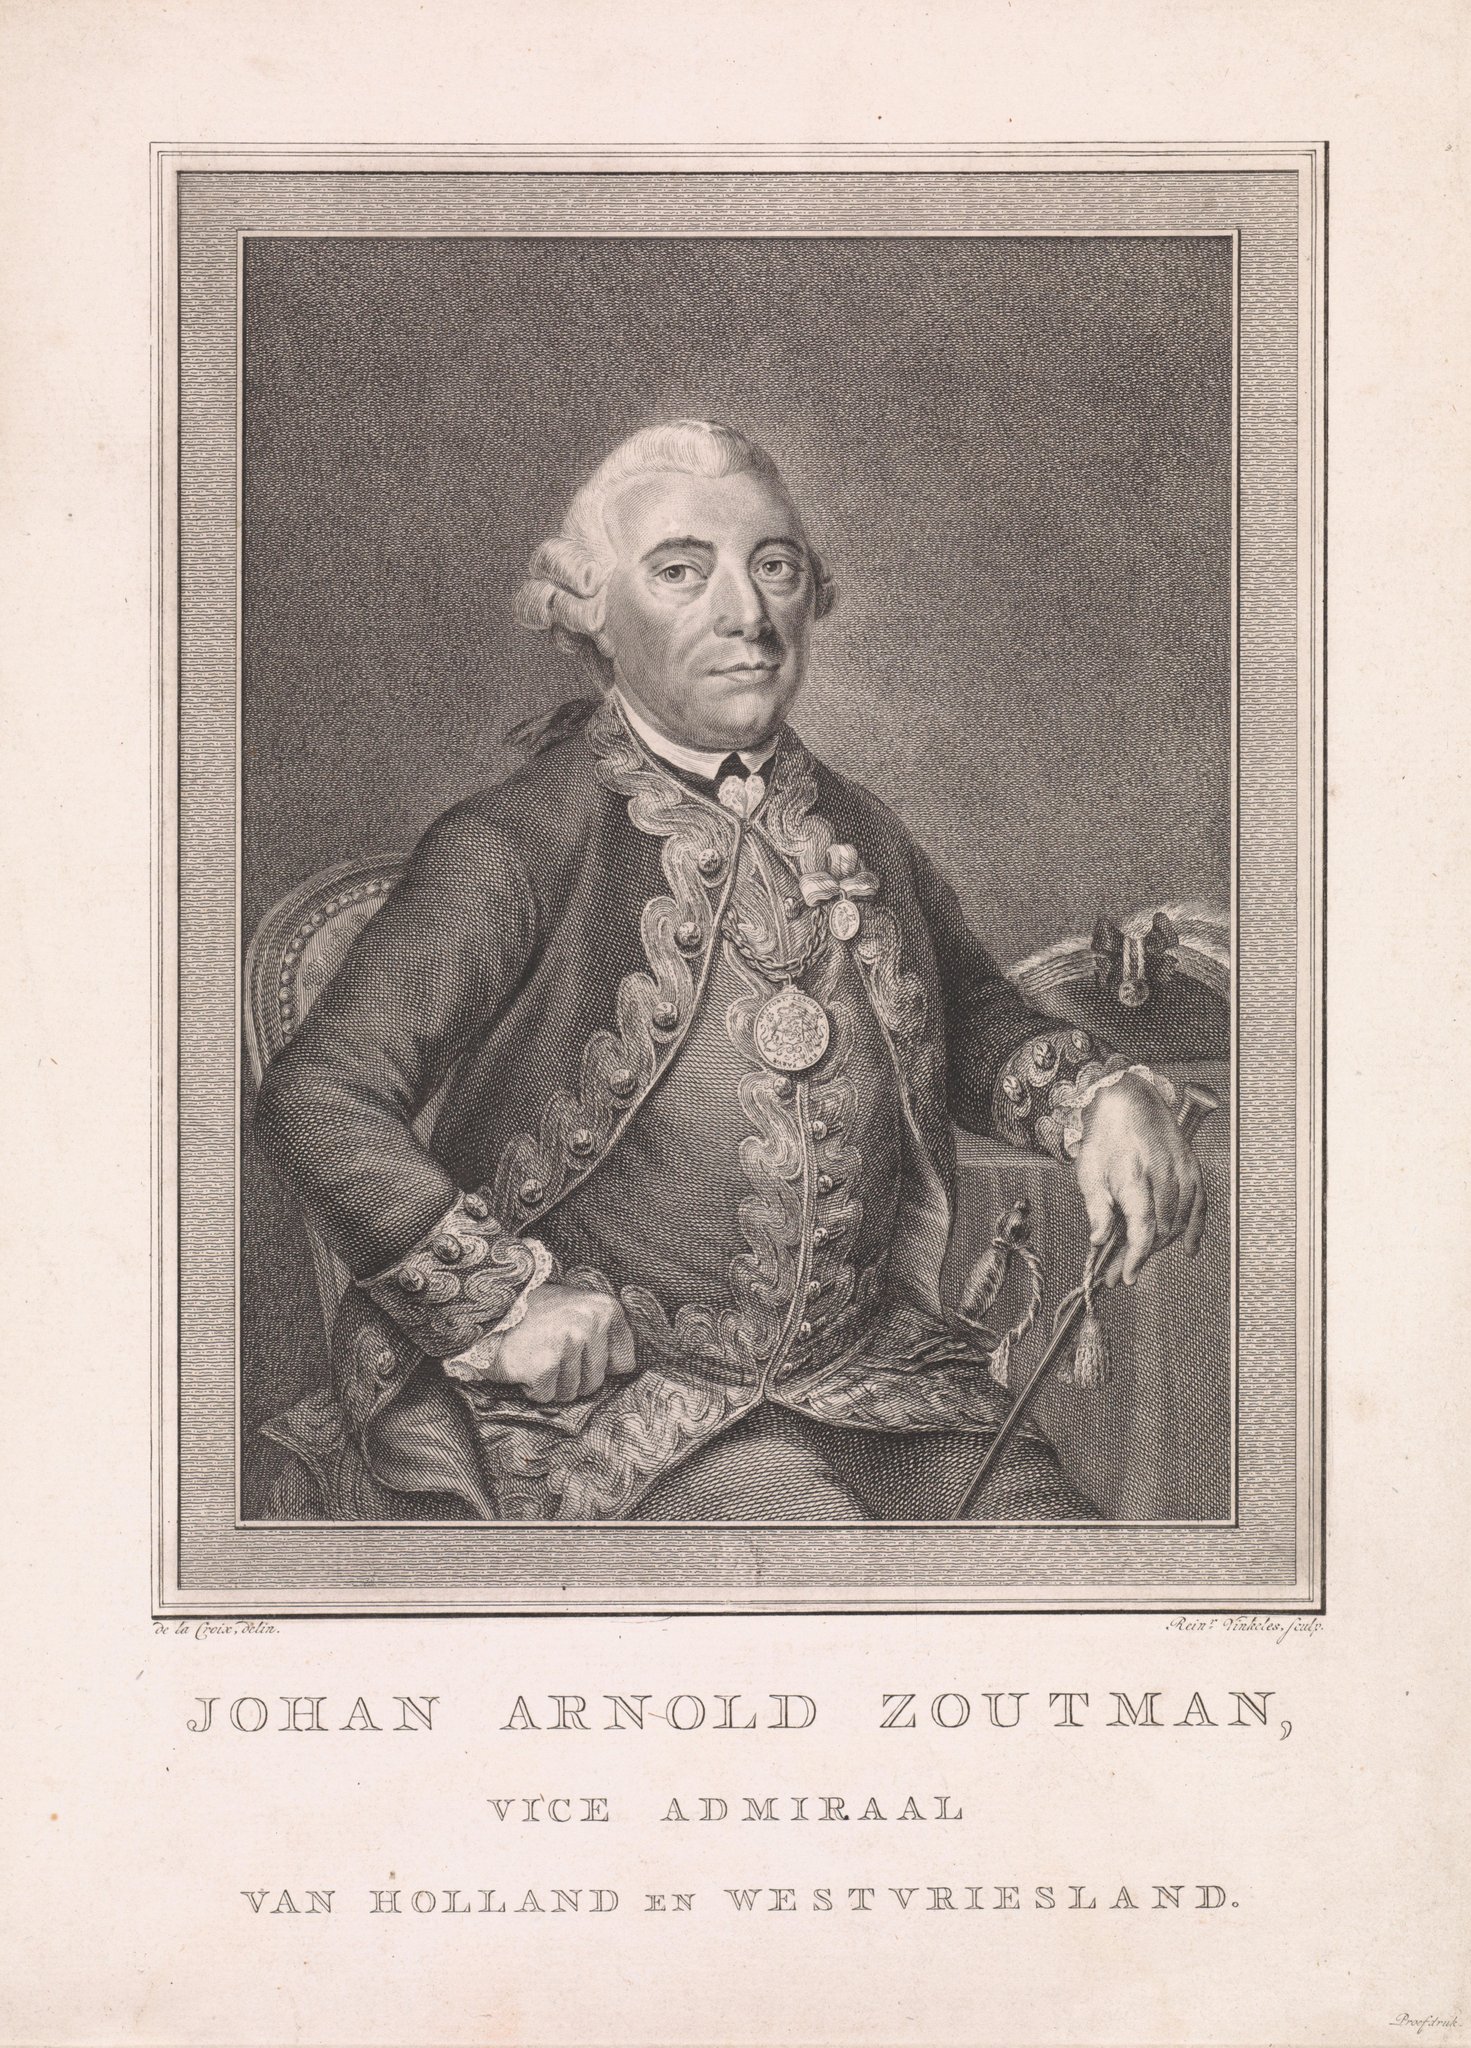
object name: print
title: Portret van Johan Arnold Zoutman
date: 1781-1816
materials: paper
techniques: engraving, etching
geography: amsterdam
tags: the hague, johan arnold zoutman, medal, badge of a guild (+ variant)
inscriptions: collector's mark: Lugt 2228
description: Portret van Johan Arnold Zoutman, zittend op een stoel, zijn elleboog leunt op een tafel. Om zijn hals zijn ontvangen gedenkpenning voor de zeeslag bij Doggersbank.